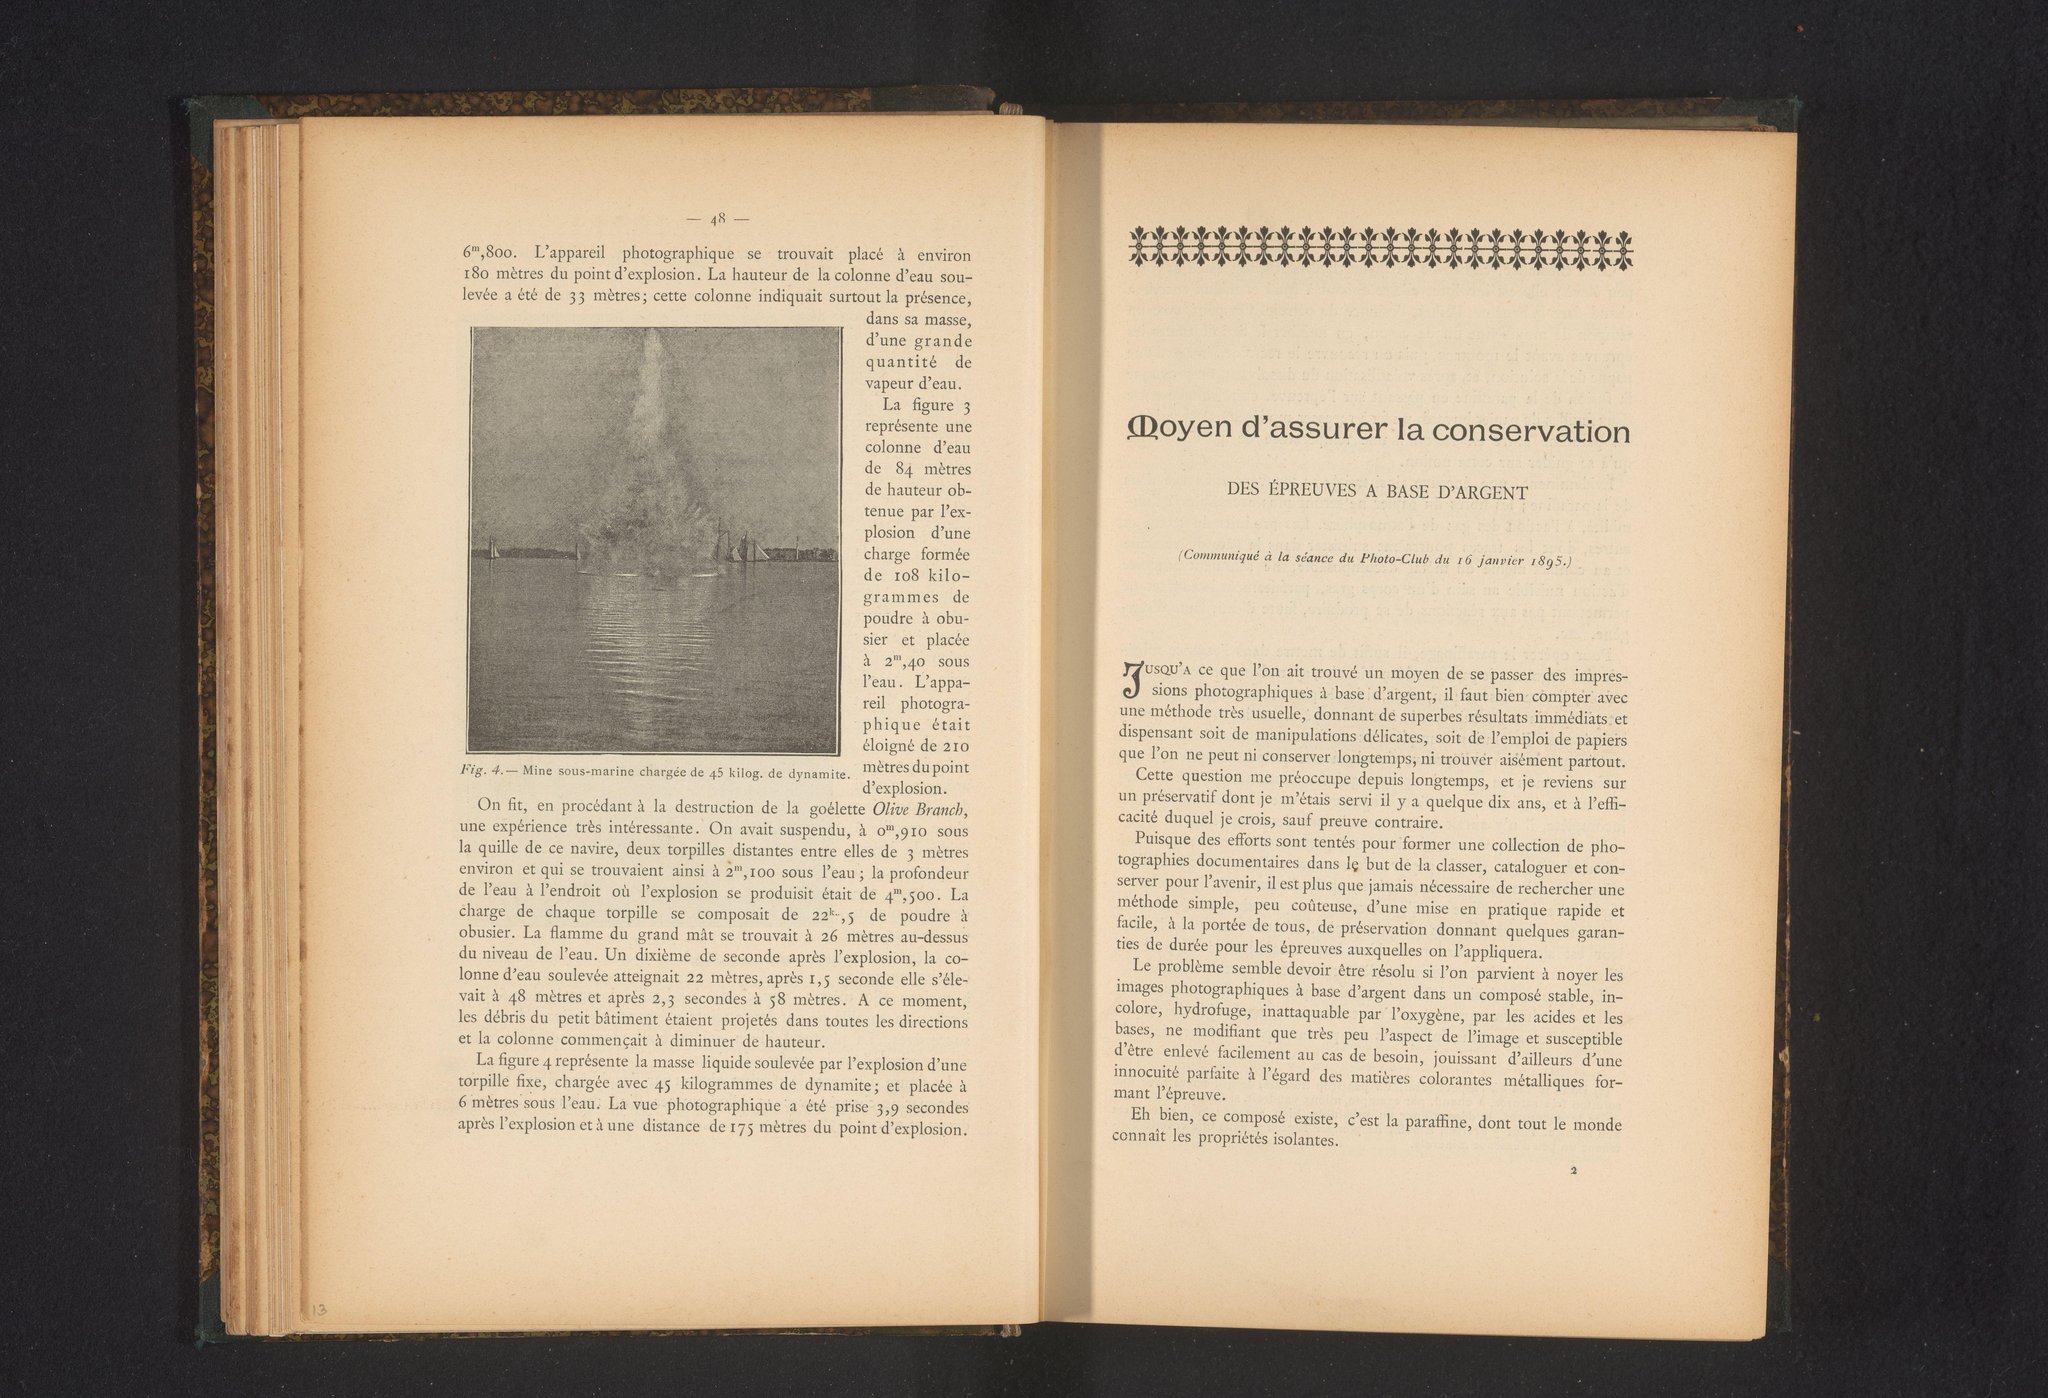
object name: photomechanical print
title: Mijn wordt onder water tot ontploffing gebracht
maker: Anonymous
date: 1890-1895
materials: paper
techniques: autotype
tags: projectiles, explosives, etc.: mine, sea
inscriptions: inscription: ‘Fig. 4. - Mine sous-marine chargée de 45 kilog. de dynamite’